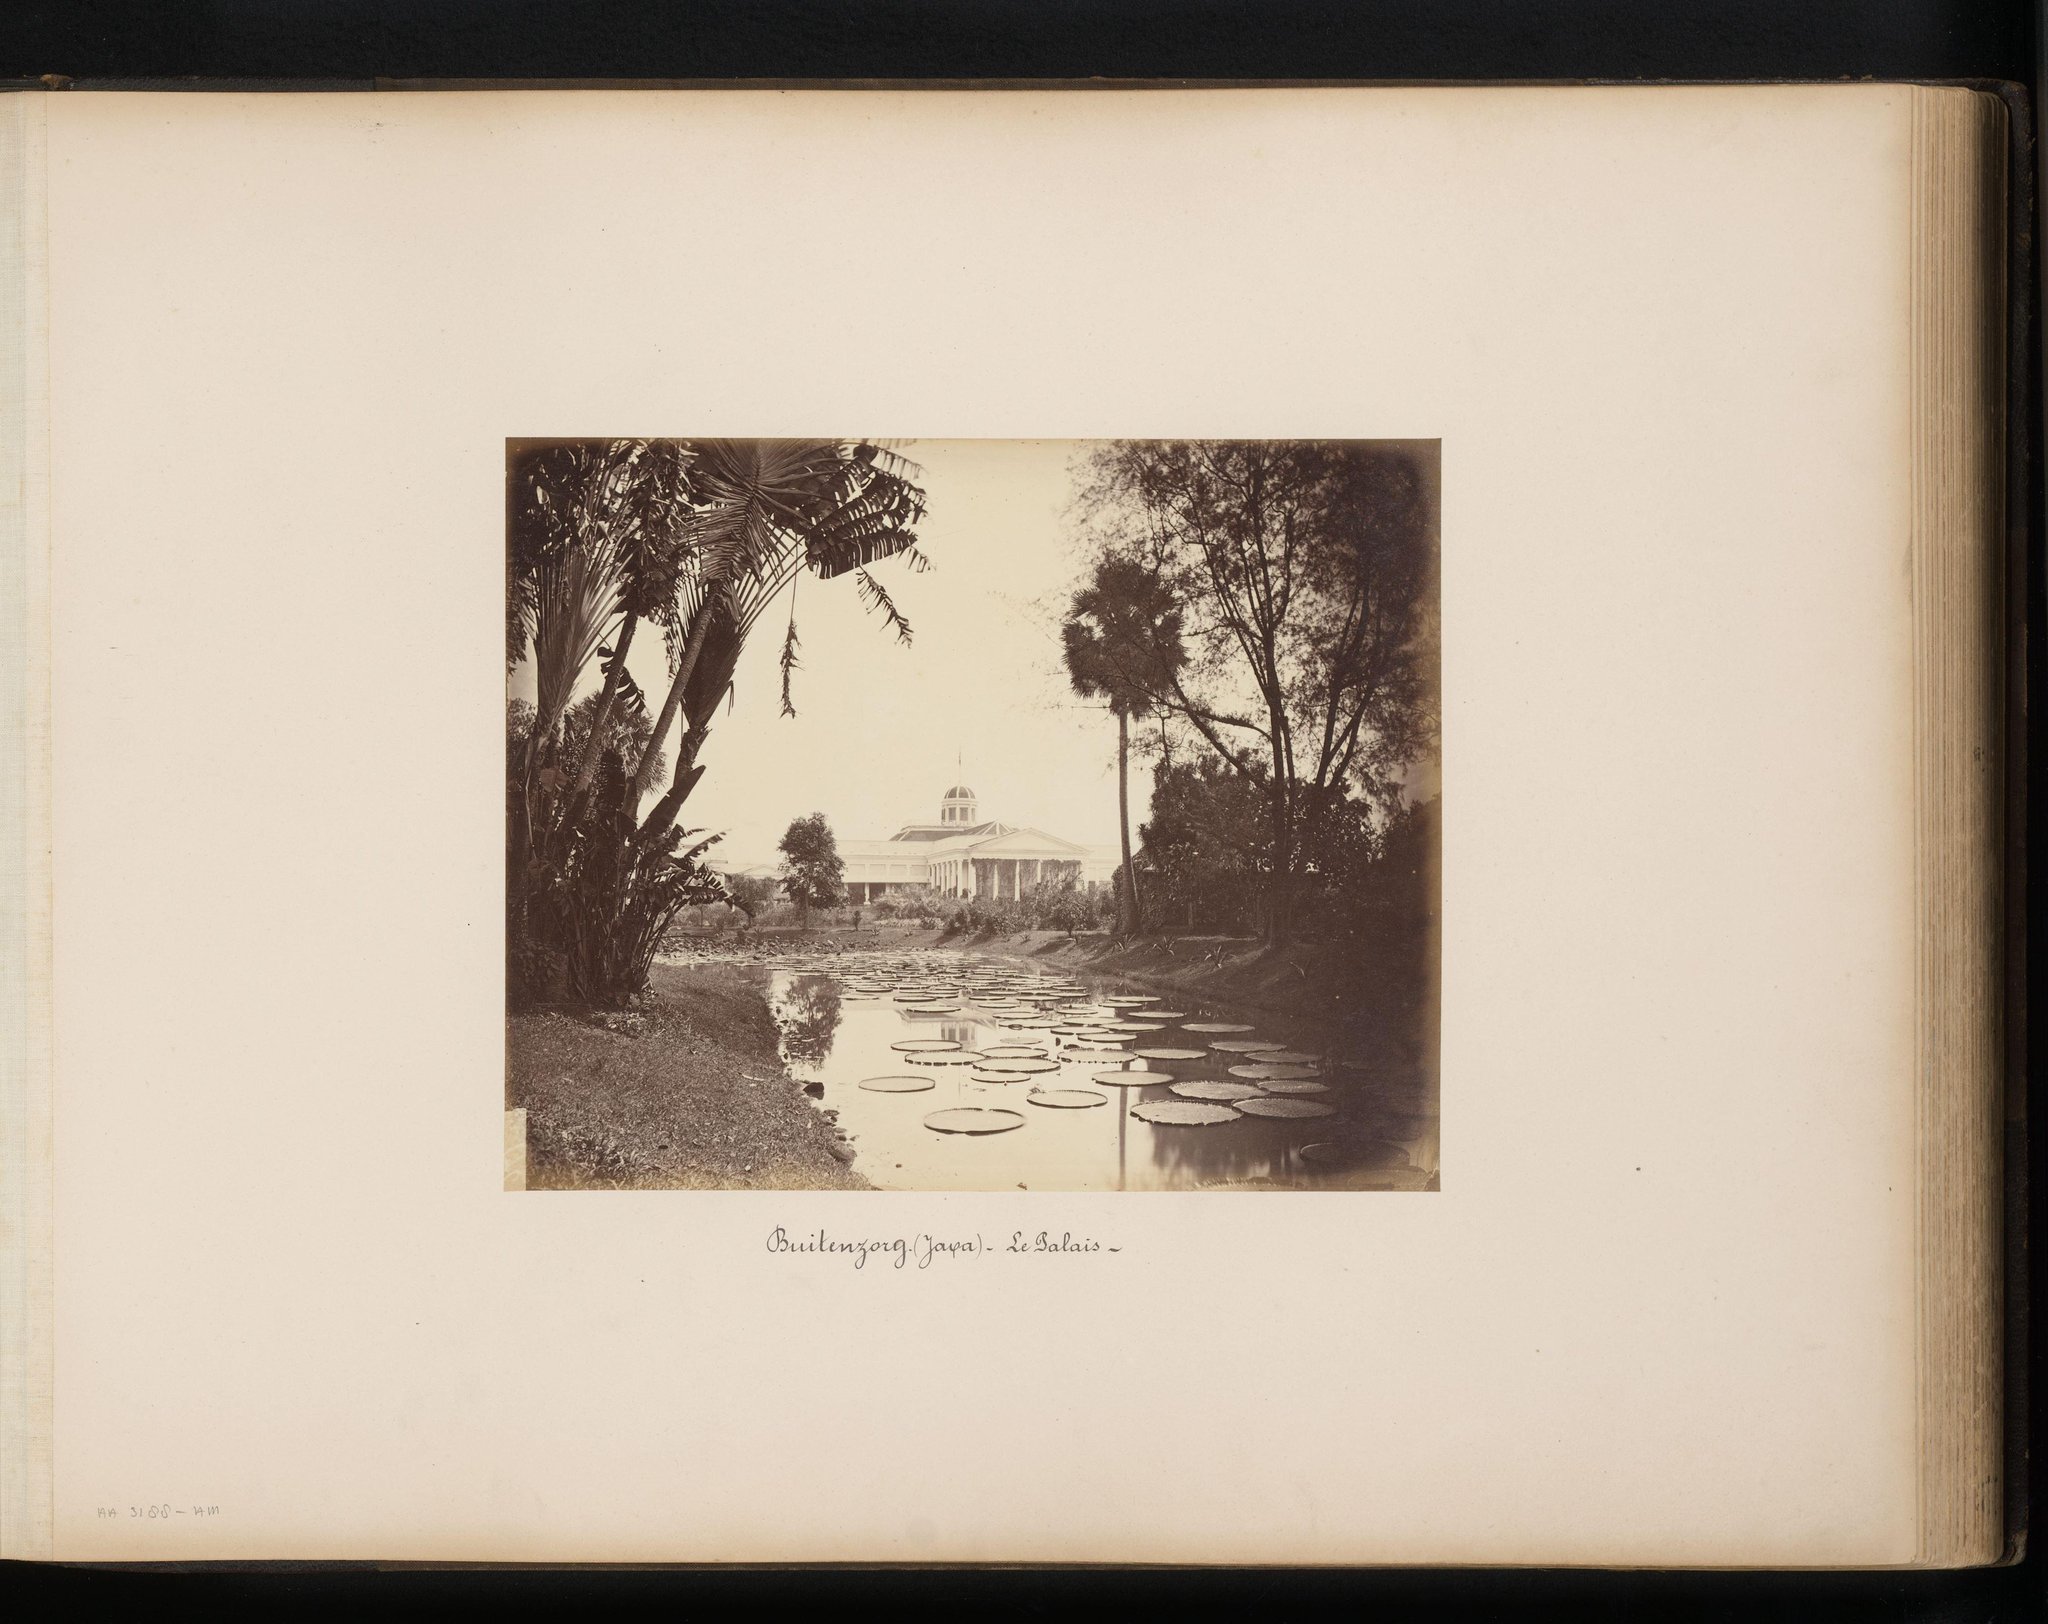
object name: photograph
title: Grote vijver met Victoria Regia in 's Lands Plantentuin met op de achtergrond het paleis van de gouverneur-generaal te Buitenzorg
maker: Anonymous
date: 1880-1883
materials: photographic support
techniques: albumen print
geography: s lands plantentuin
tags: flowers: water-lily, palace, botanic garden, 'hortus botanicus'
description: Onderdeel van Reisalbum met opnames van bezienswaardigheden in Egypte, Nederlands-Indië, Singapore en Ceylon.